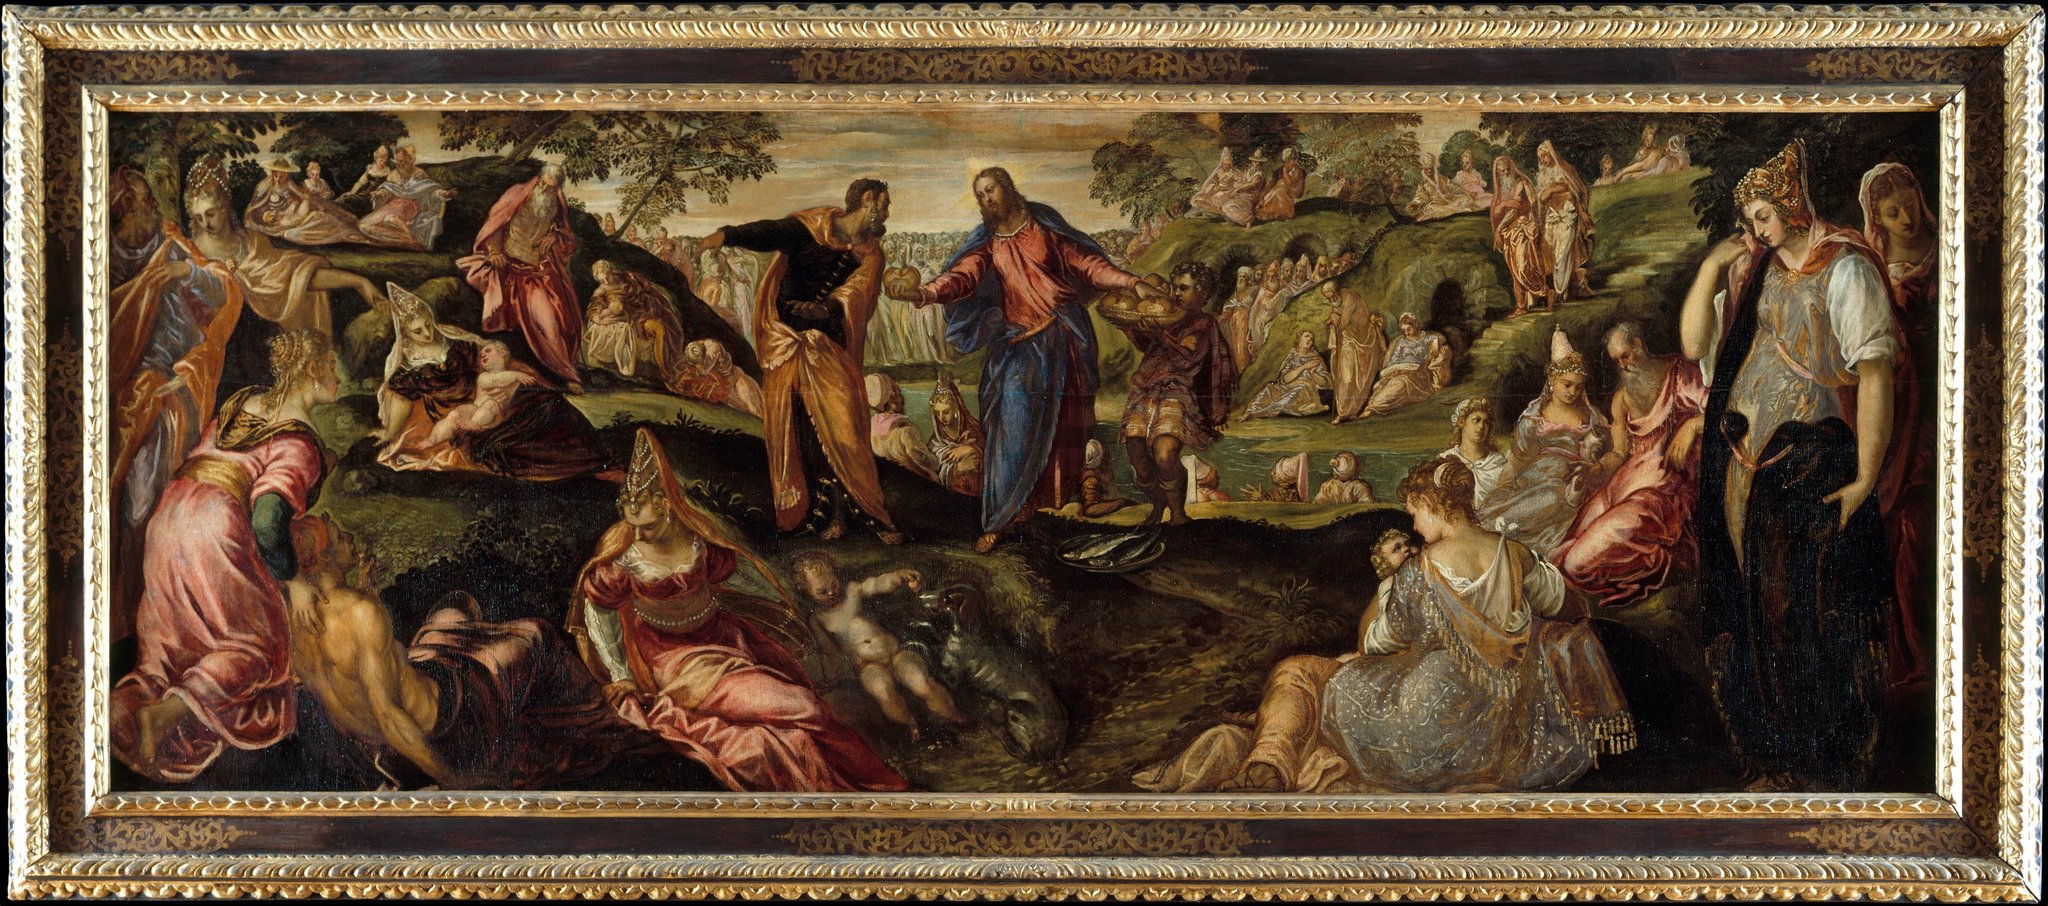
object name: painting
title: The Miracle of the Loaves and Fishes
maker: jacopo tintoretto (jacopo robusti)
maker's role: artist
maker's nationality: italian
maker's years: 1518-1594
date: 1545-1550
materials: canvas, oil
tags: bread,men,women,dogs,fish,landscapes,christ